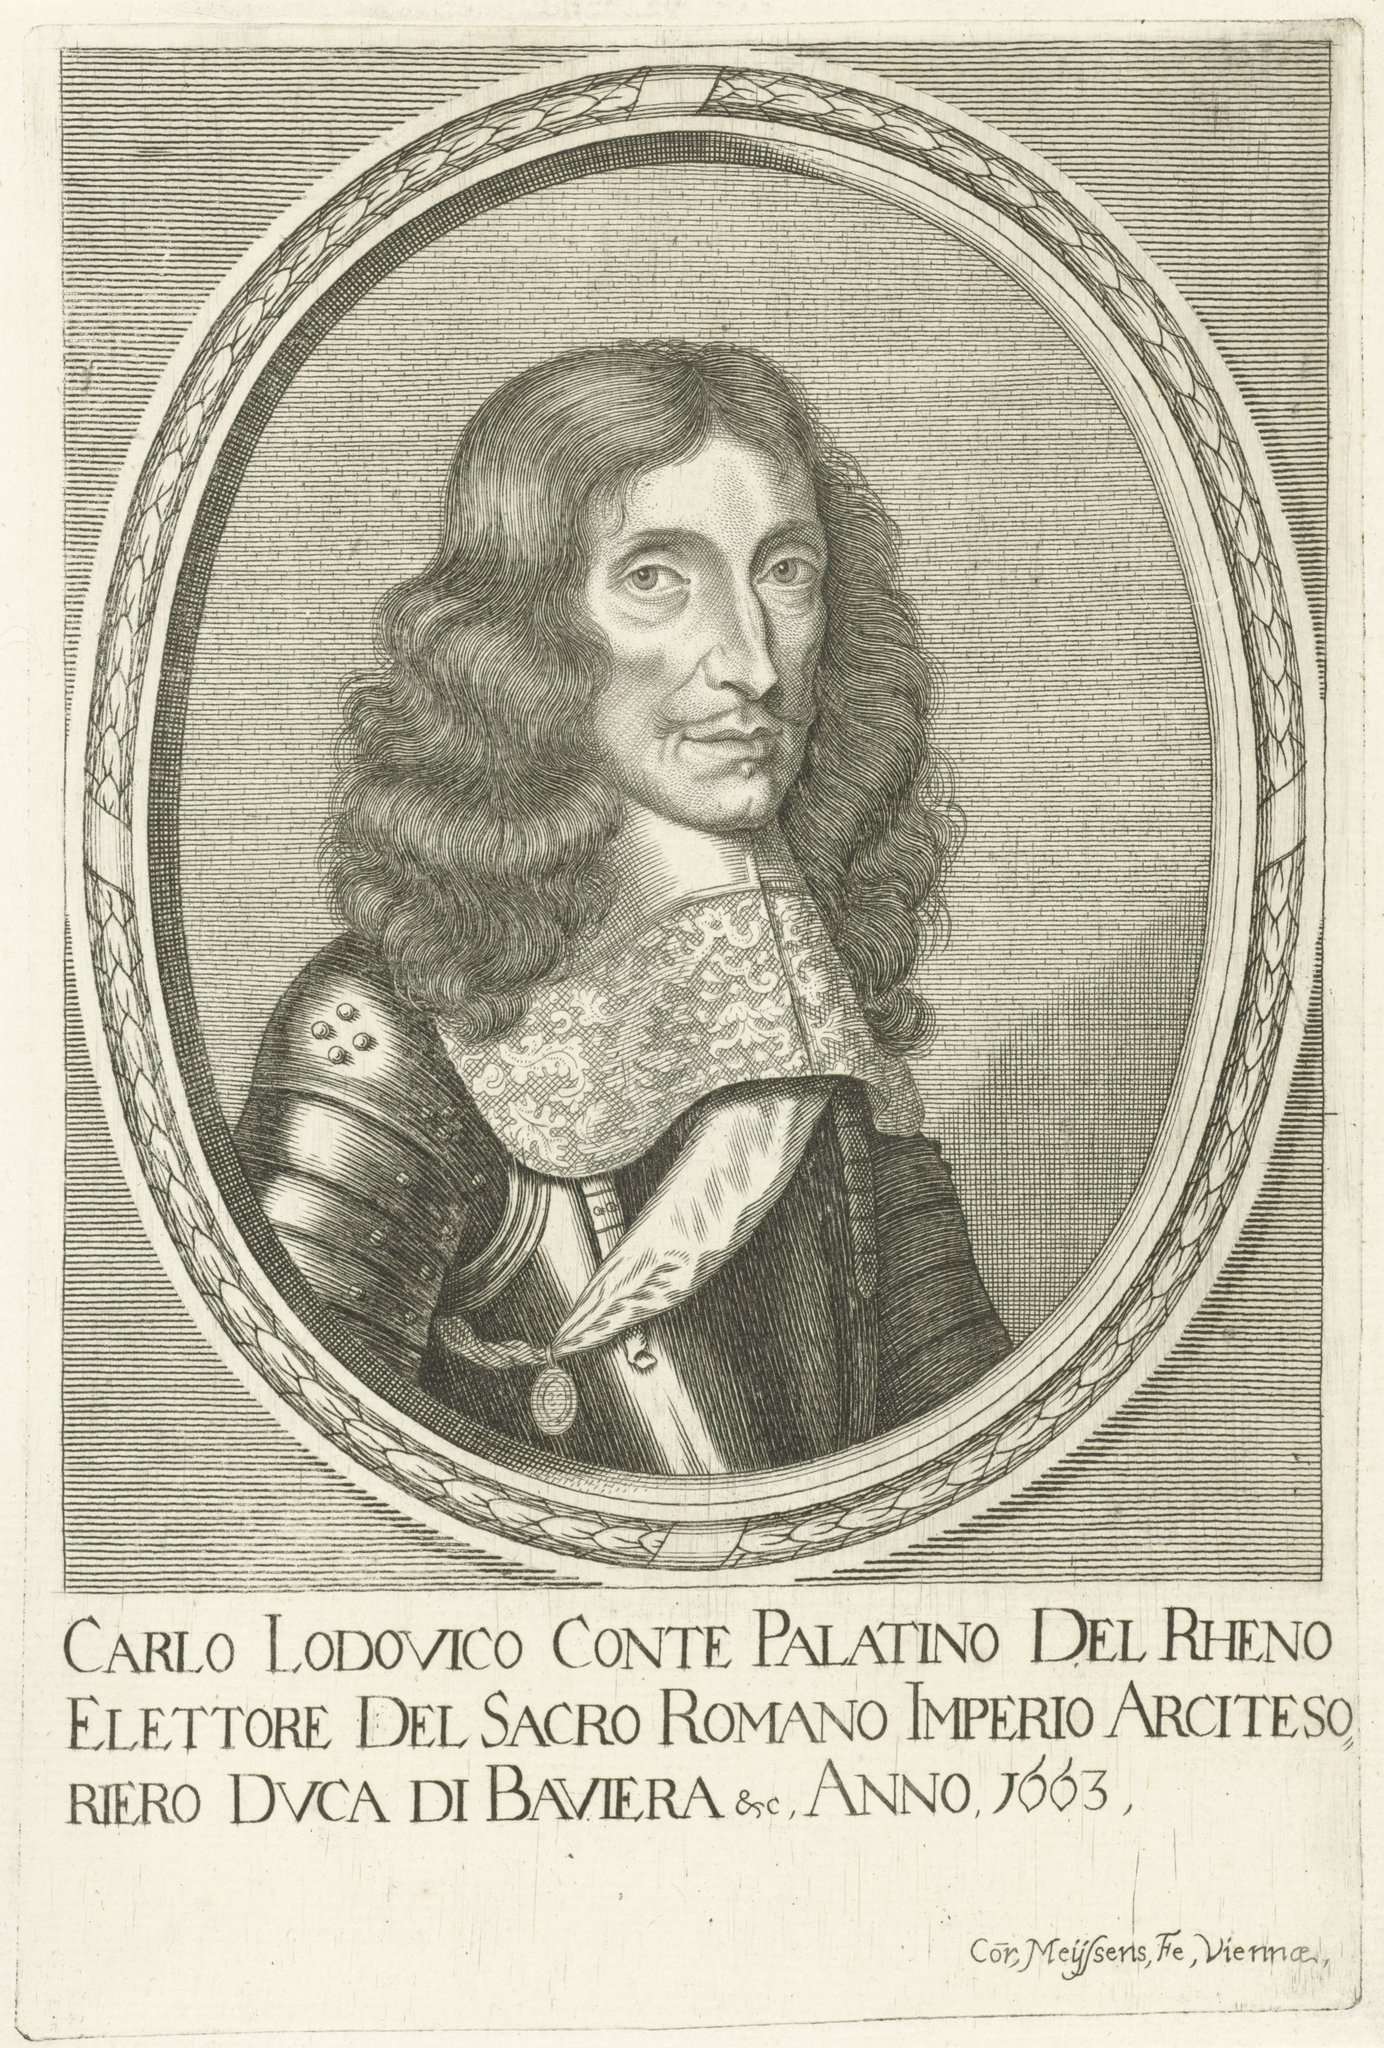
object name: book illustration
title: Portret van Karel Lodewijk, keurvorst van de Palts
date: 1670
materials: paper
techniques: engraving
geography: vienna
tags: heidelberg, edingen, keurvorst, keurvorst van de palts karel lodewijk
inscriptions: collector's mark: Lugt 2228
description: Prent gebruikt in: Gualdo Priorato, Galeazzo. Historia di Leopoldo Cesare, (...). 3 dln. Wenen, Giovanni Battista Hacque, 1670-1674, dl. 1.